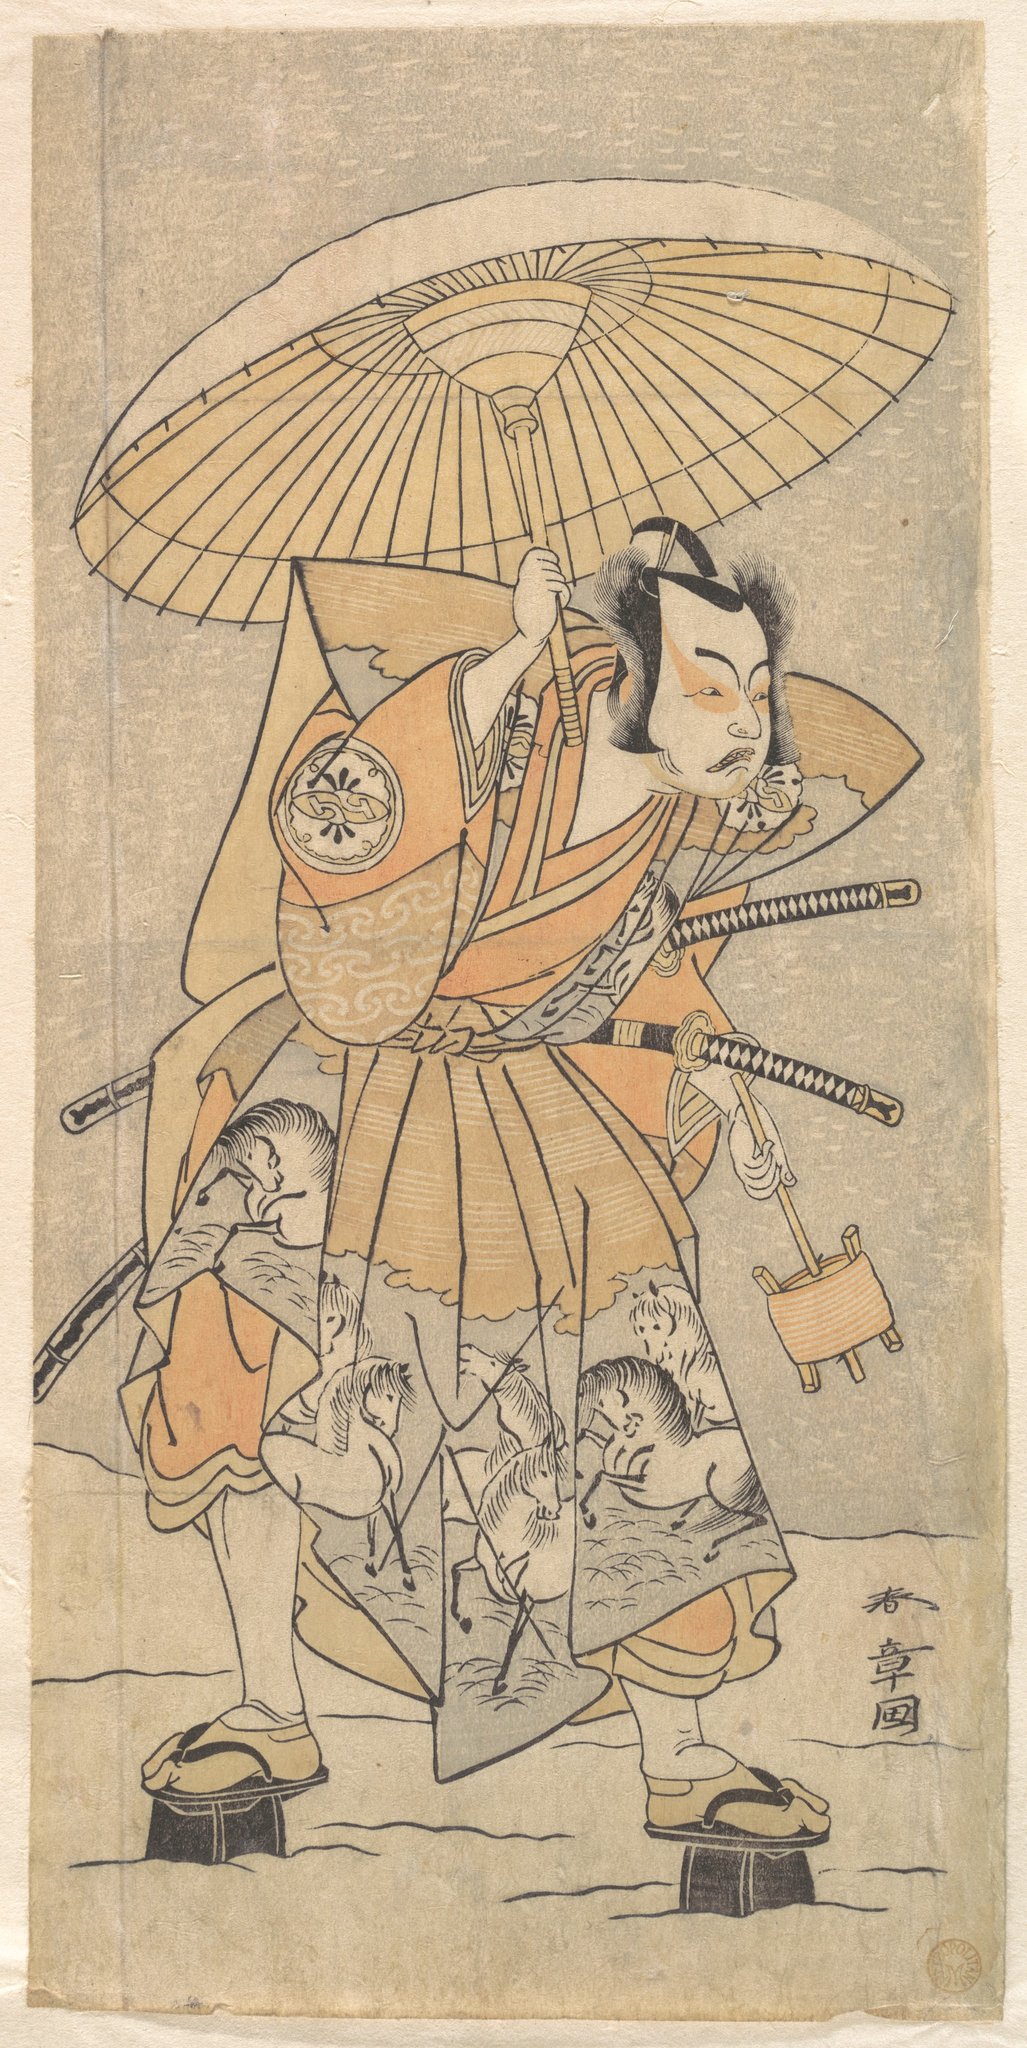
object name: woodblock print nishiki e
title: The Second Nakamura Juzo as a Samurai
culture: japanese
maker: katsukawa shunshō 勝川春章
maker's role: artist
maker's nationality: japanese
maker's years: 1726-1792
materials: ink, paper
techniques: nishiki e, woodblock print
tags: swords,men,actors